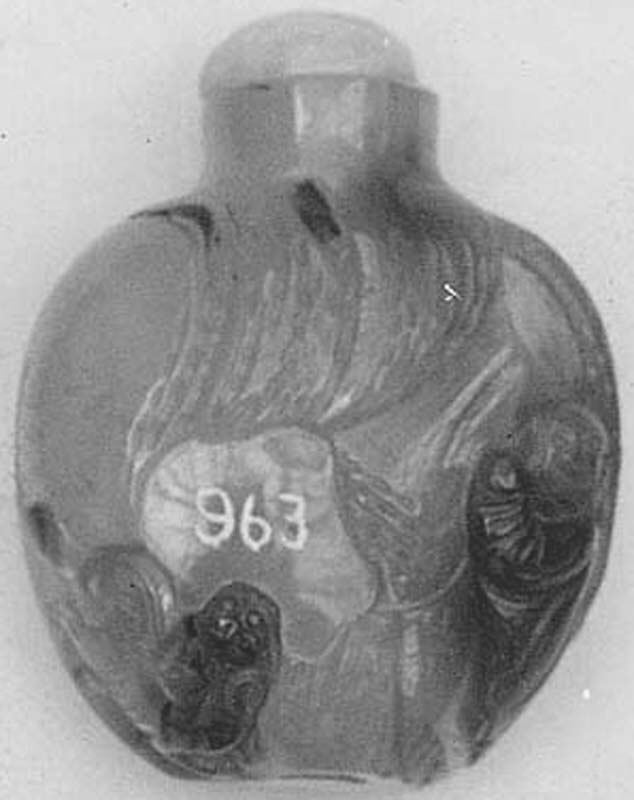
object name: snuff bottle with stopper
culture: chinese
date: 1701-1900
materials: stone, jade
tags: human figures